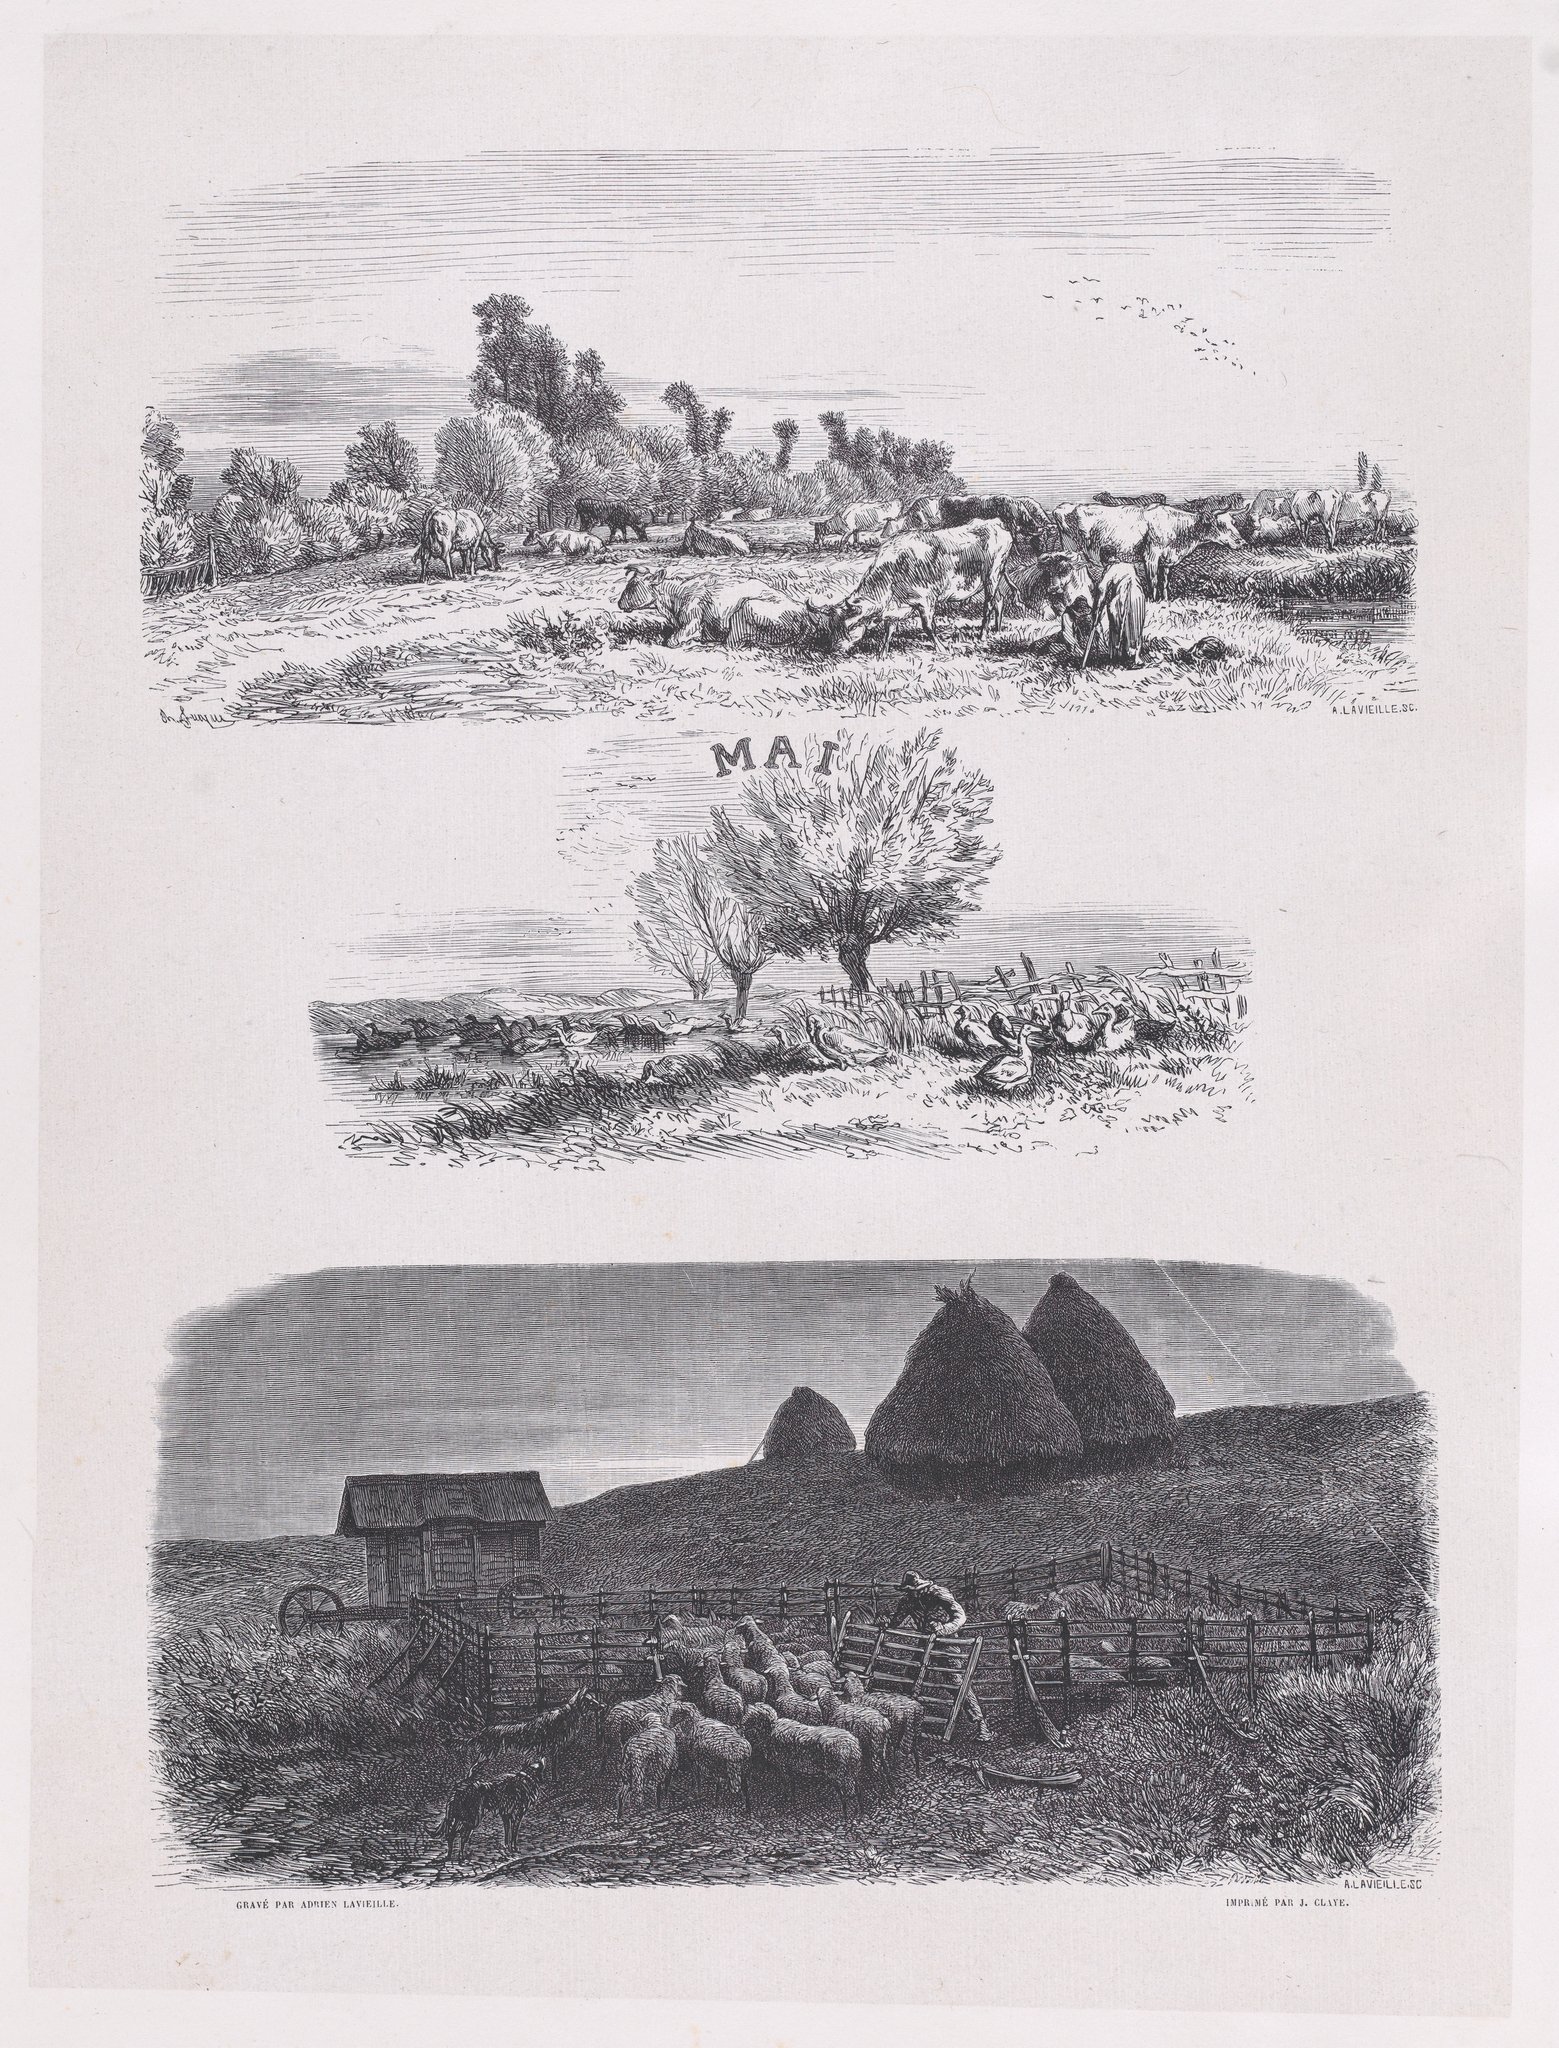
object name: print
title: May, from "Album of Rustic Subjects"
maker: charles émile jacque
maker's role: artist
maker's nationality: french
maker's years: 1813-1894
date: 1859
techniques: engraving